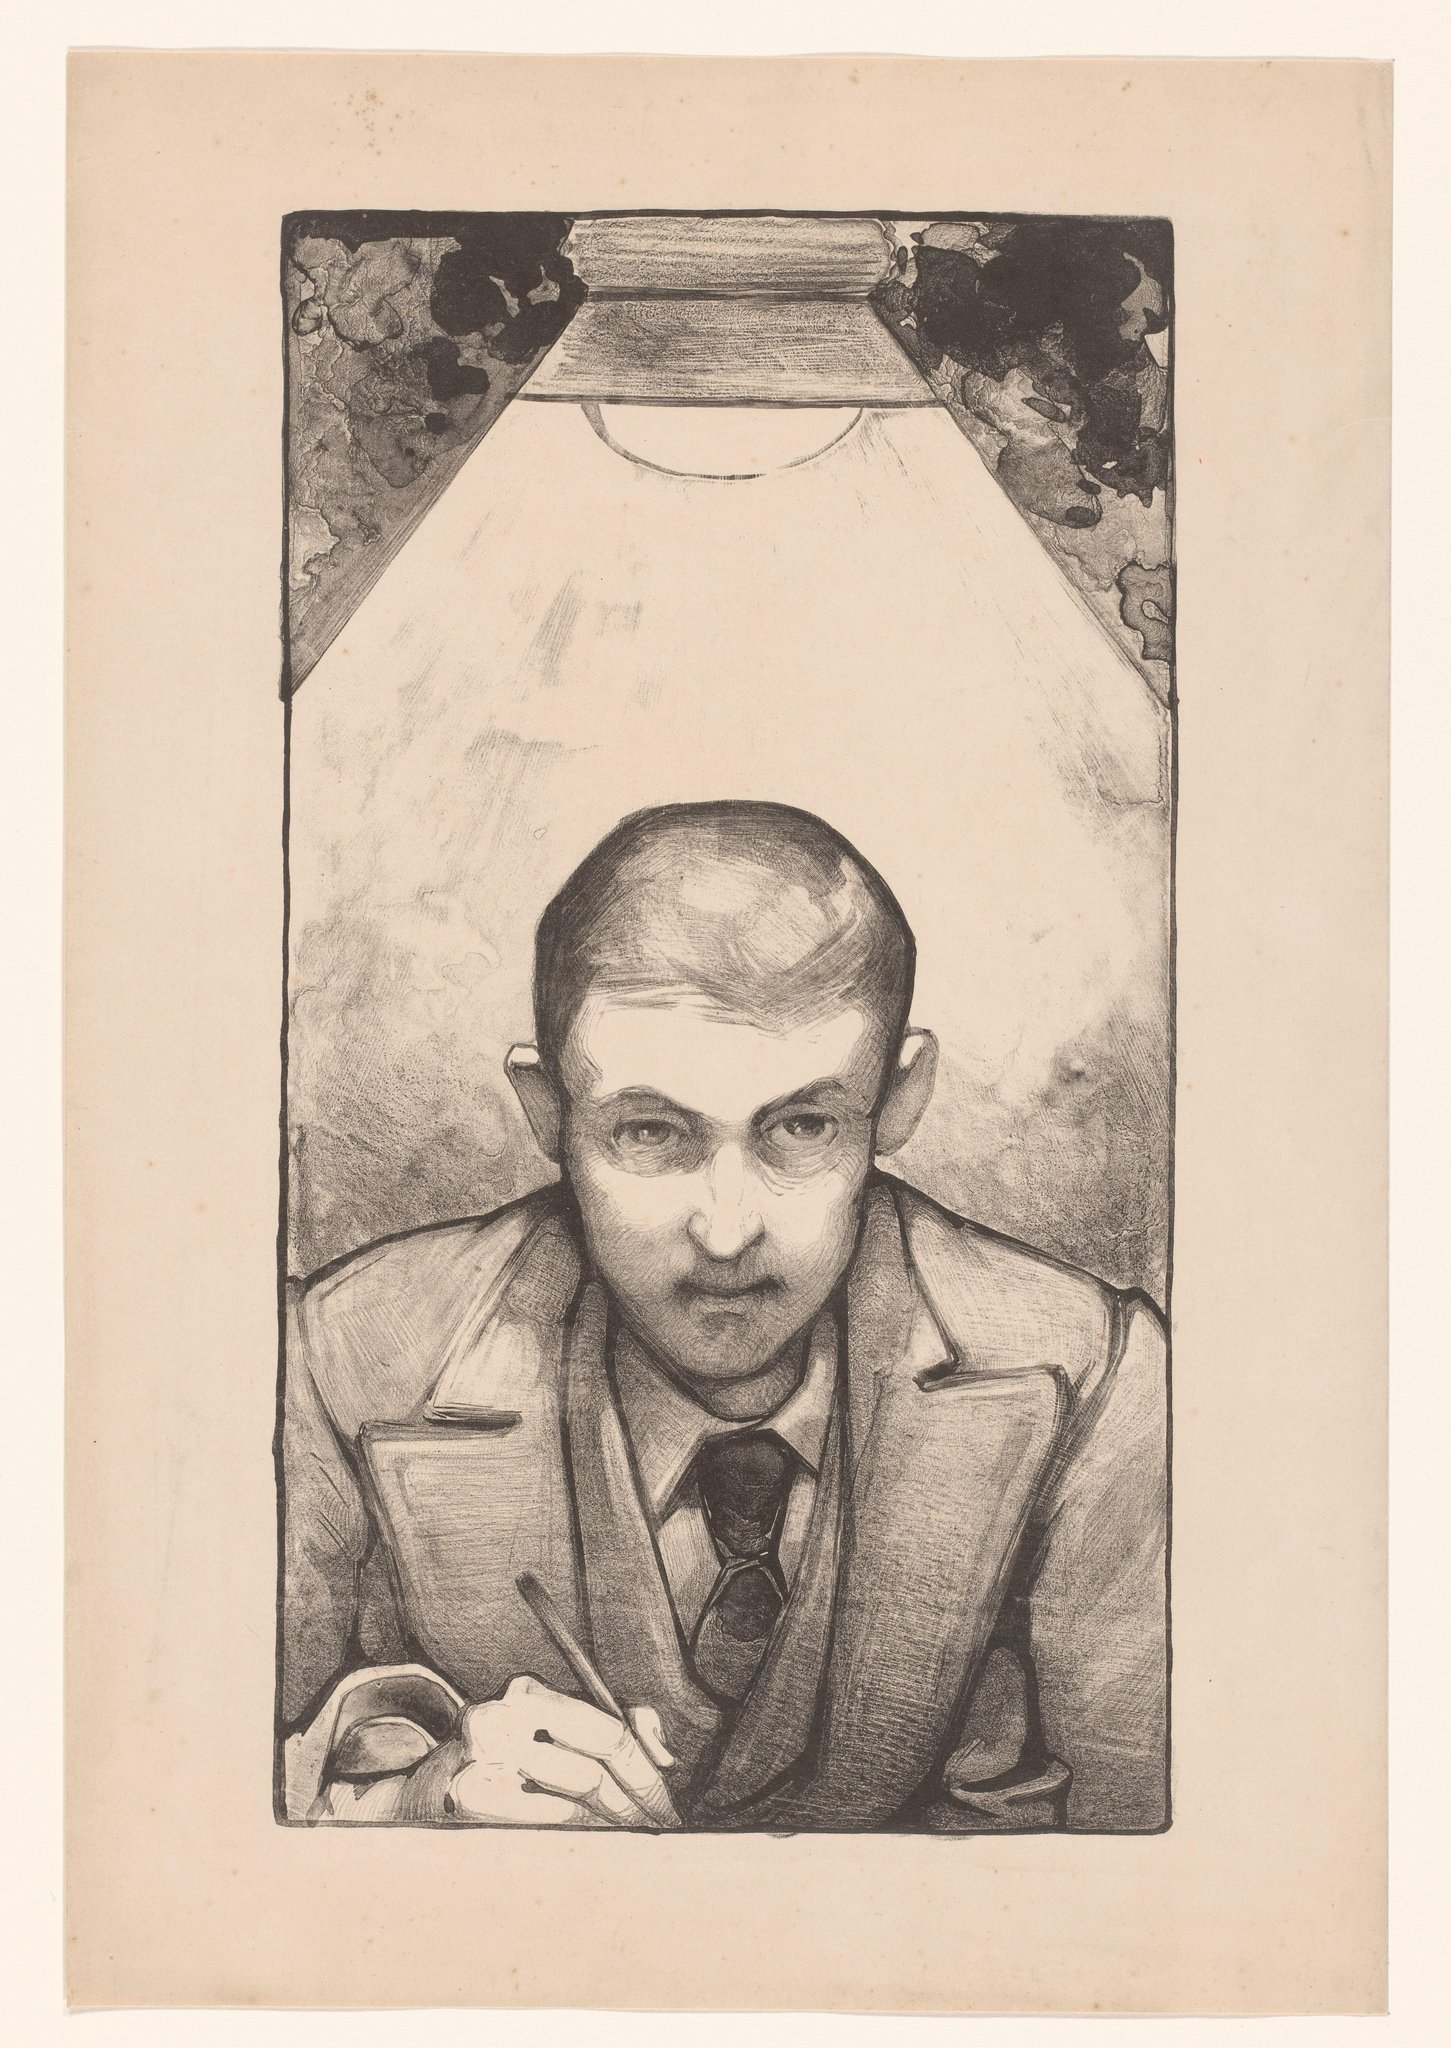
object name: print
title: Zelfportret onder lamp, tekenend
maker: bernard willem wierink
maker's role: draughtsman, print maker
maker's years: 1856-1939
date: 1889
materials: paper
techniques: lithograph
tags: portrait, self-portrait of artist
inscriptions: collector's mark: Lugt 2760, collector's mark: Lugt 2228